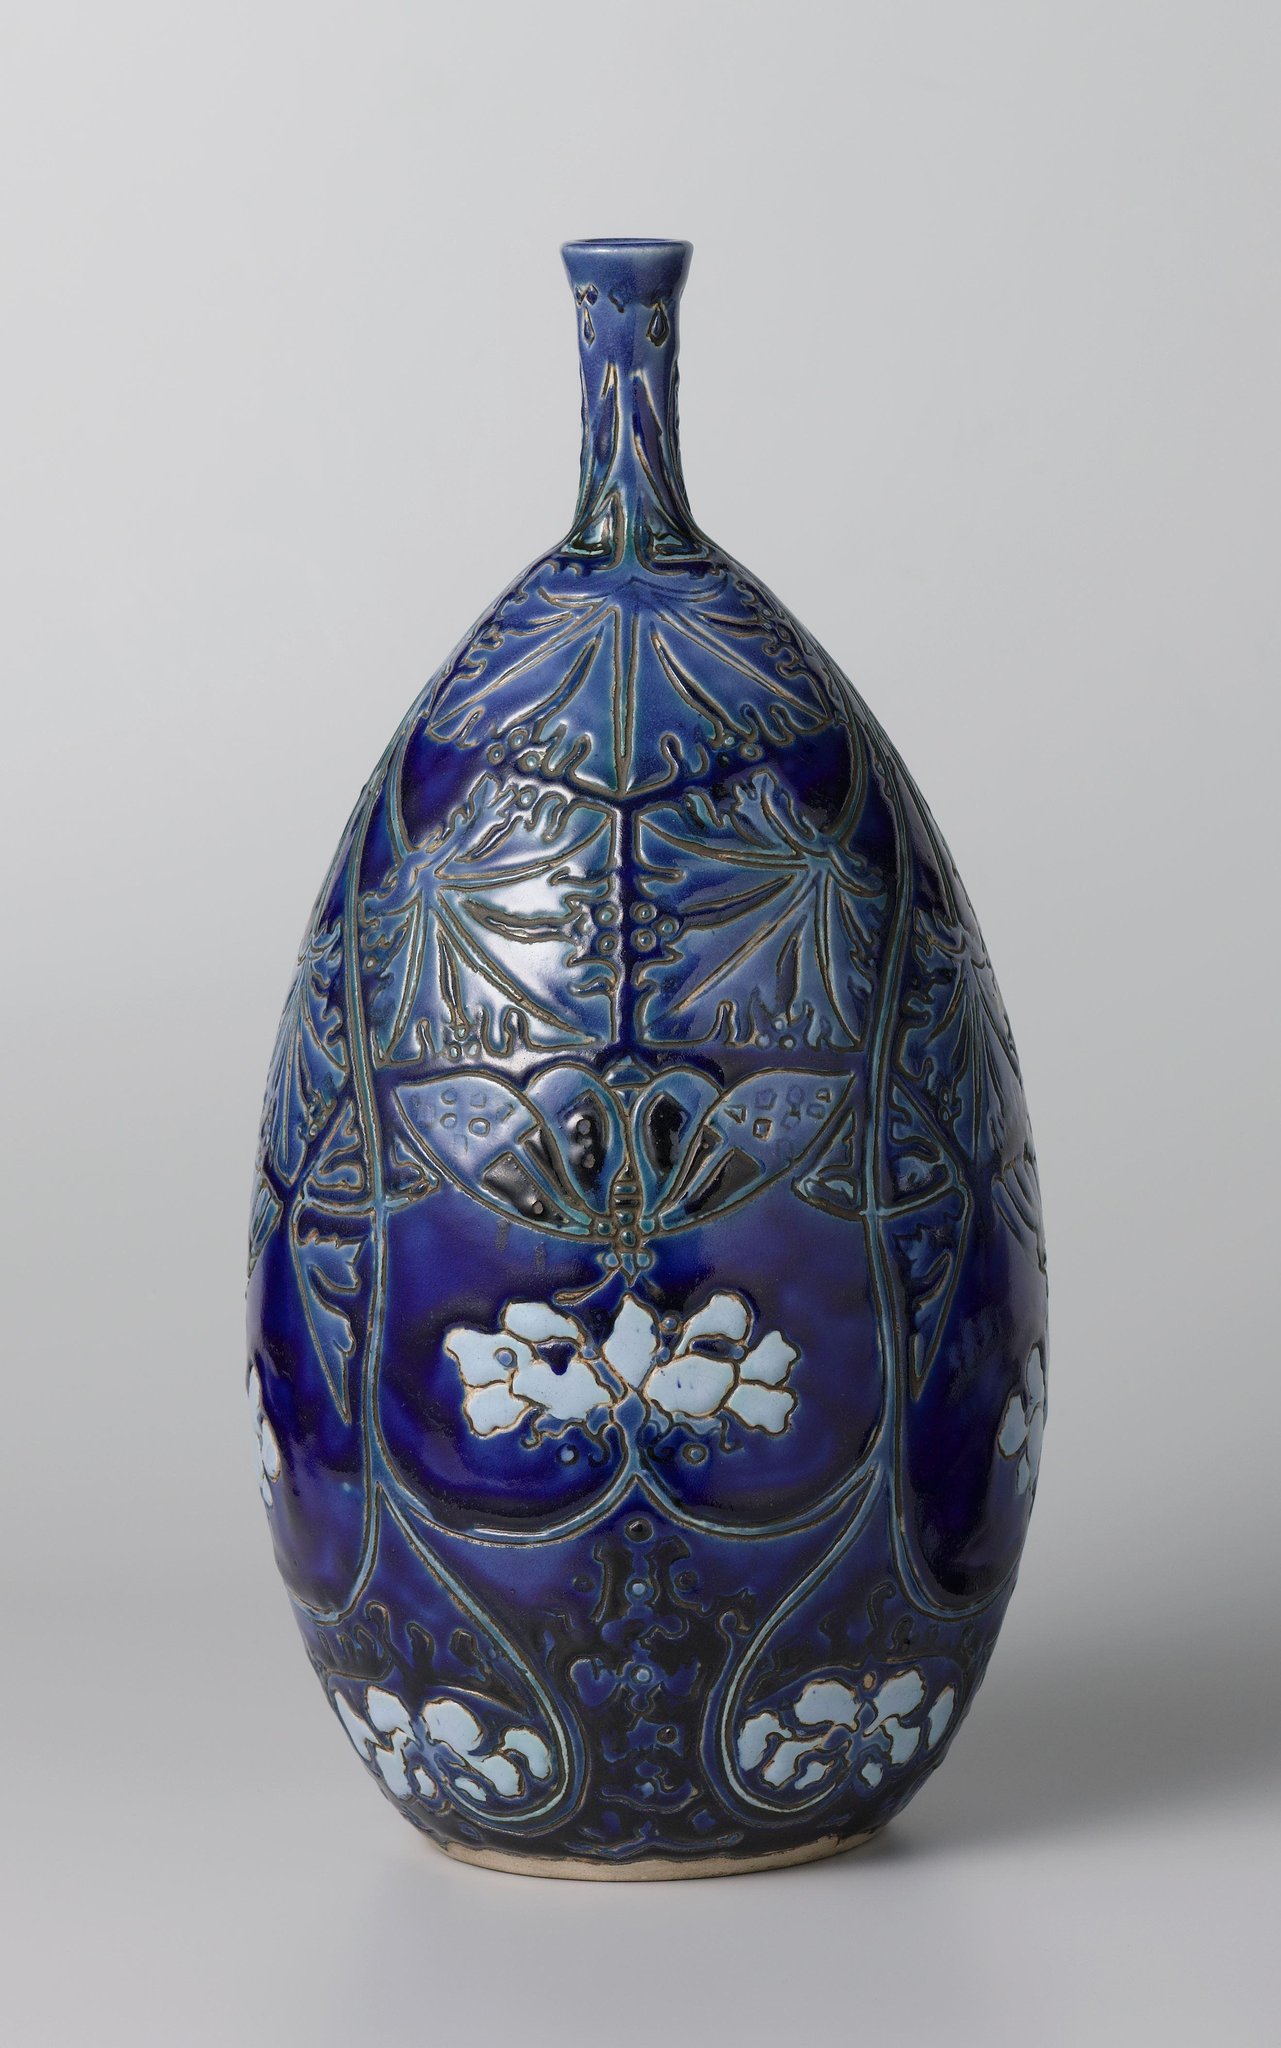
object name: vase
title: Vaas, versierd met bloemen, bladeren en vlinders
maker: theo nieuwenhuis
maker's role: designer, draughtsman, print maker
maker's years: 1866-1951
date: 1915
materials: earthenware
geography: amsterdam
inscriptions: mark: ‘DISTEL; fecit Th.N; in zwart: No C2081 f40,-’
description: Two vases. Earthenware decorated in the cuerda seca-technique, known as carduus earthenware. Amsterdam, c. 1915, made by Plateelbakkerij De Distel, designed by Theodorus W. Nieuwenhuis, factory under the direction of J.M. Lob.